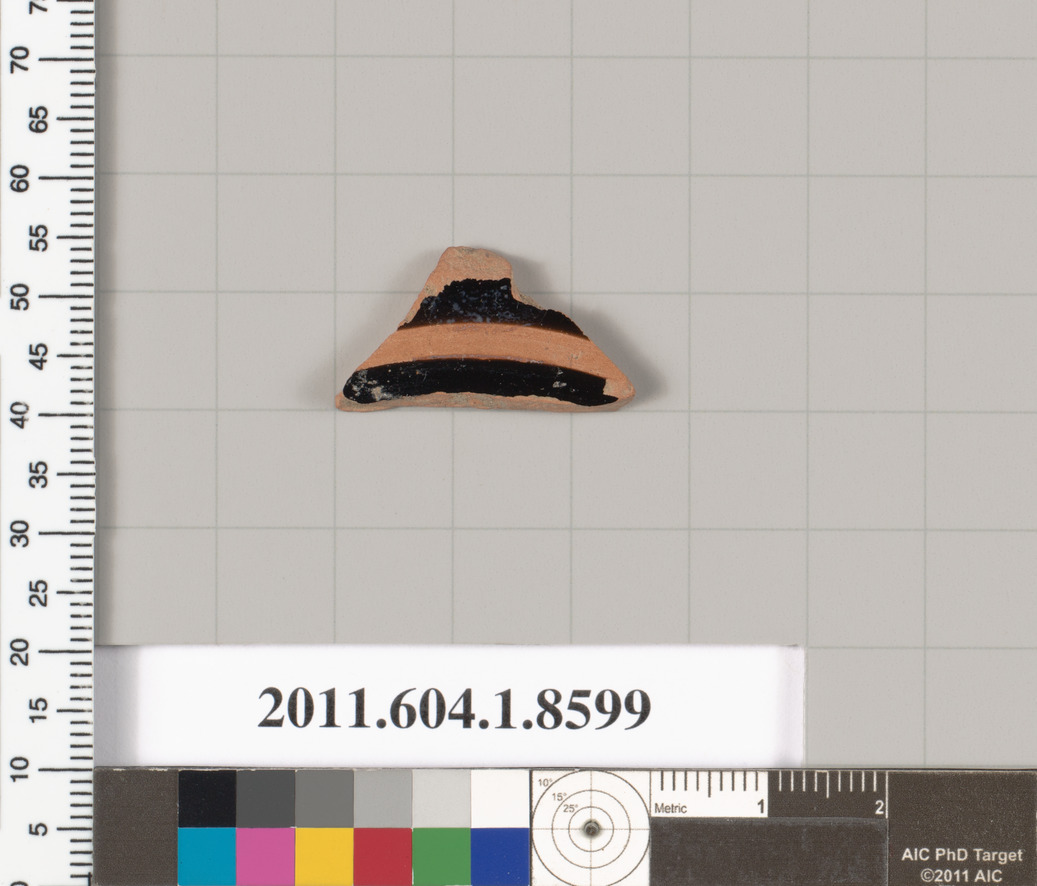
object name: kylix fragment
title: Terracotta fragment of a stemless kylix (drinking cup)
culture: greek, attic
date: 460-450 BCE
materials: terracotta